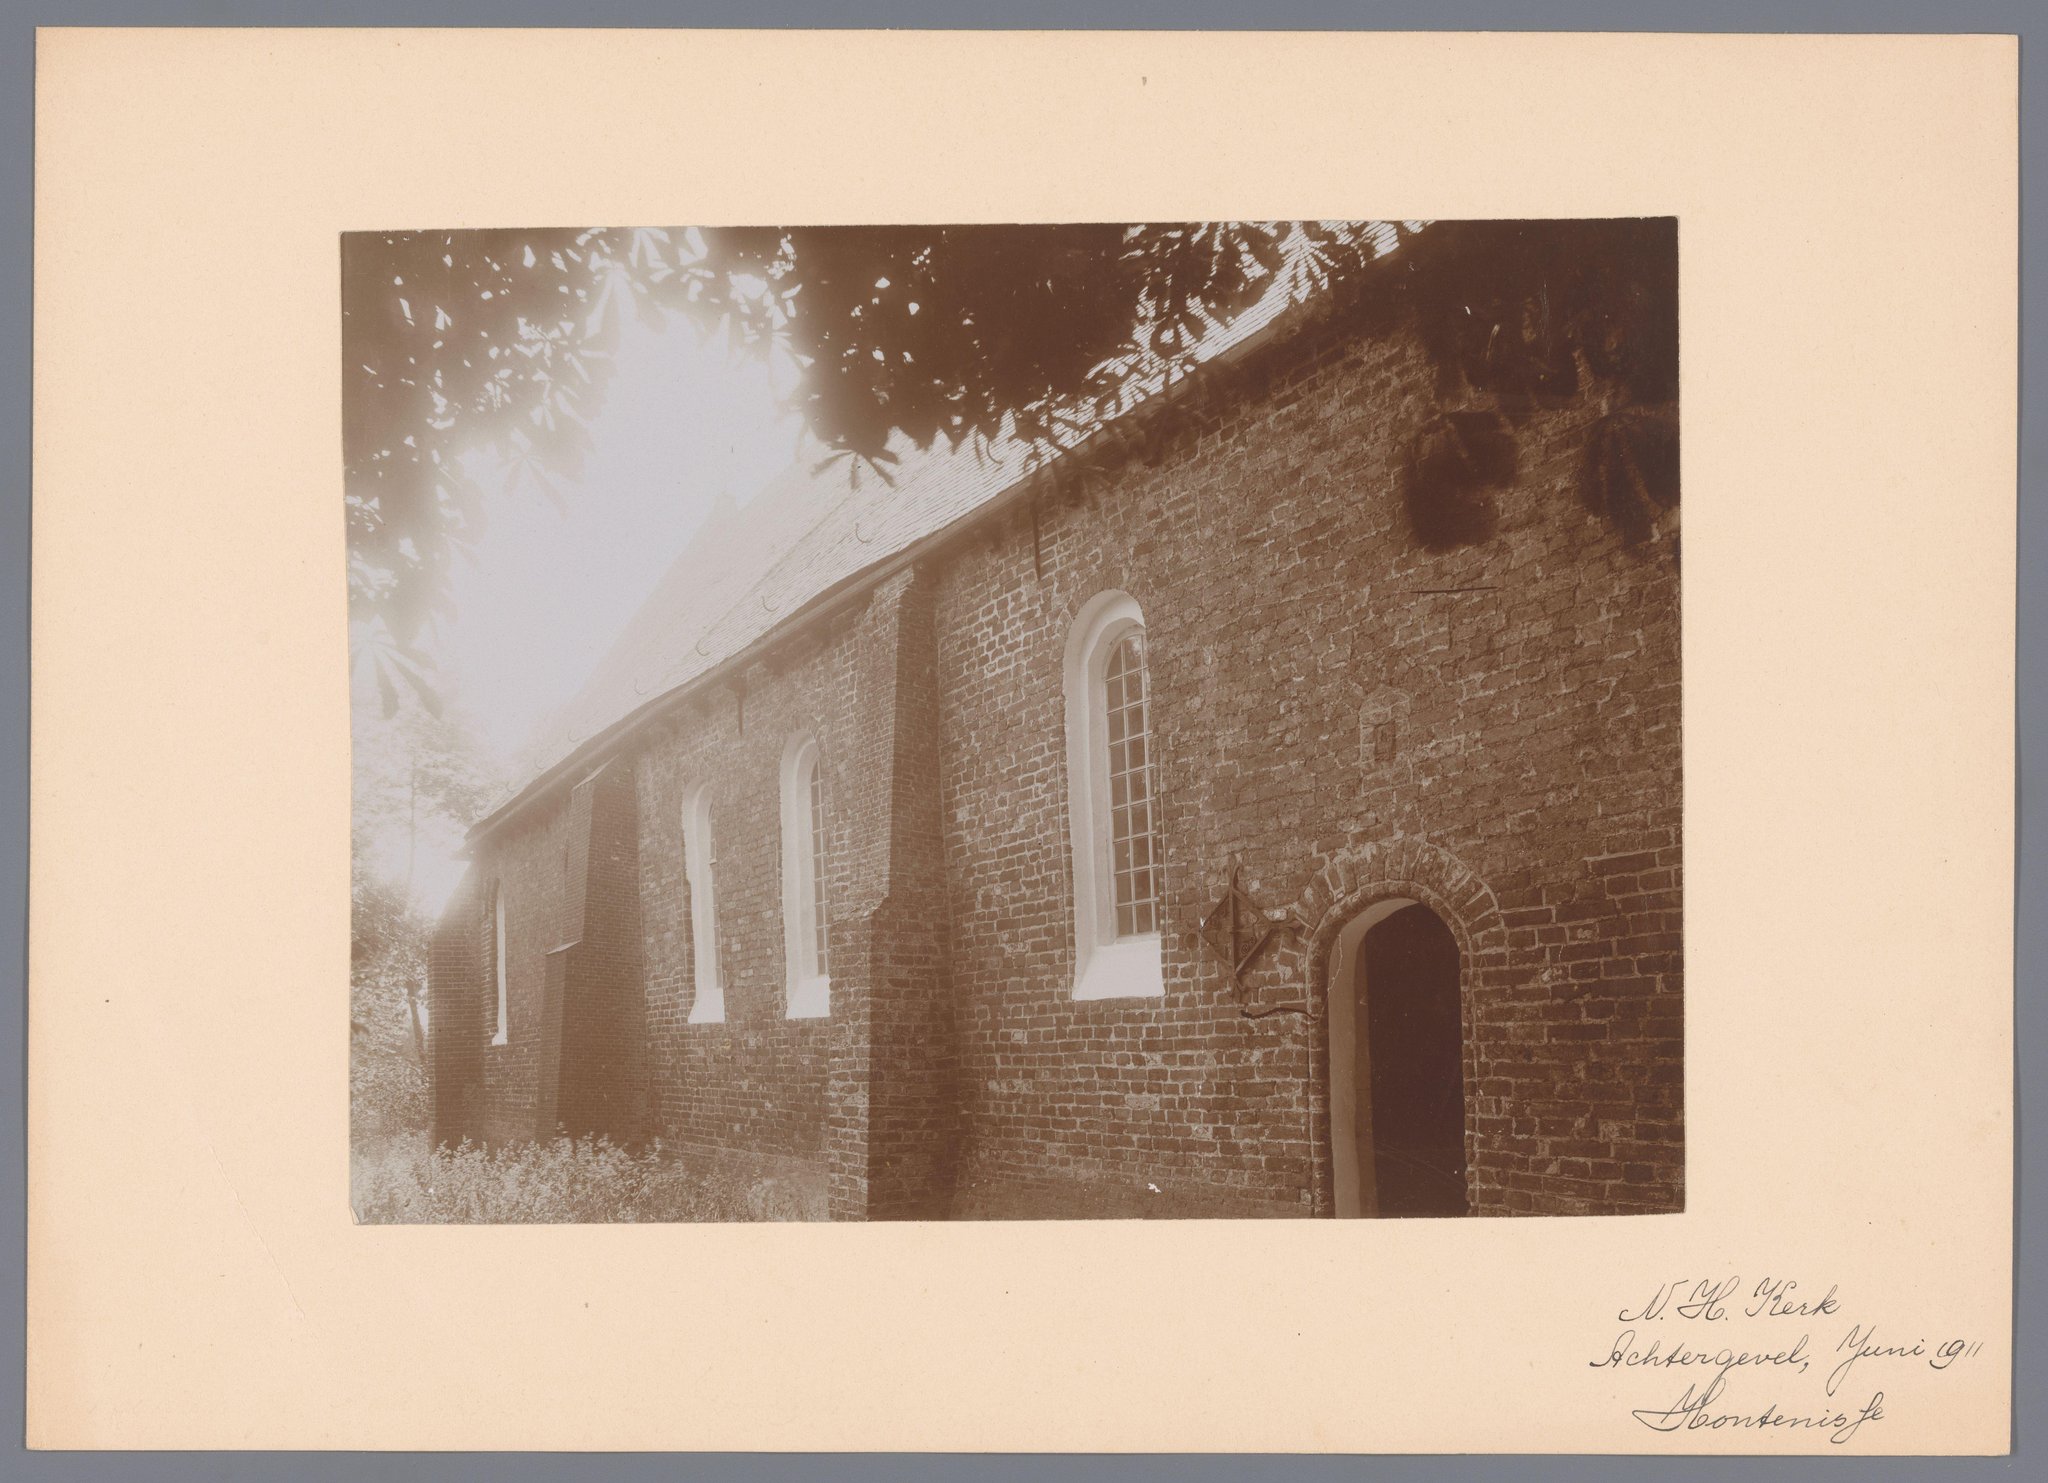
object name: photograph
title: Achtergevel van de Hervormde Kerk te Hulst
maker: anoniem (monumentenzorg)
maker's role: fotograaf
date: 1911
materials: cardboard, photographic support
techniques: collodion silver print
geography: hulst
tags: church (exterior)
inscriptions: annotation: ‘N.H. Kerk/ Achtergevel, Juni 1911/ Hontenisse’